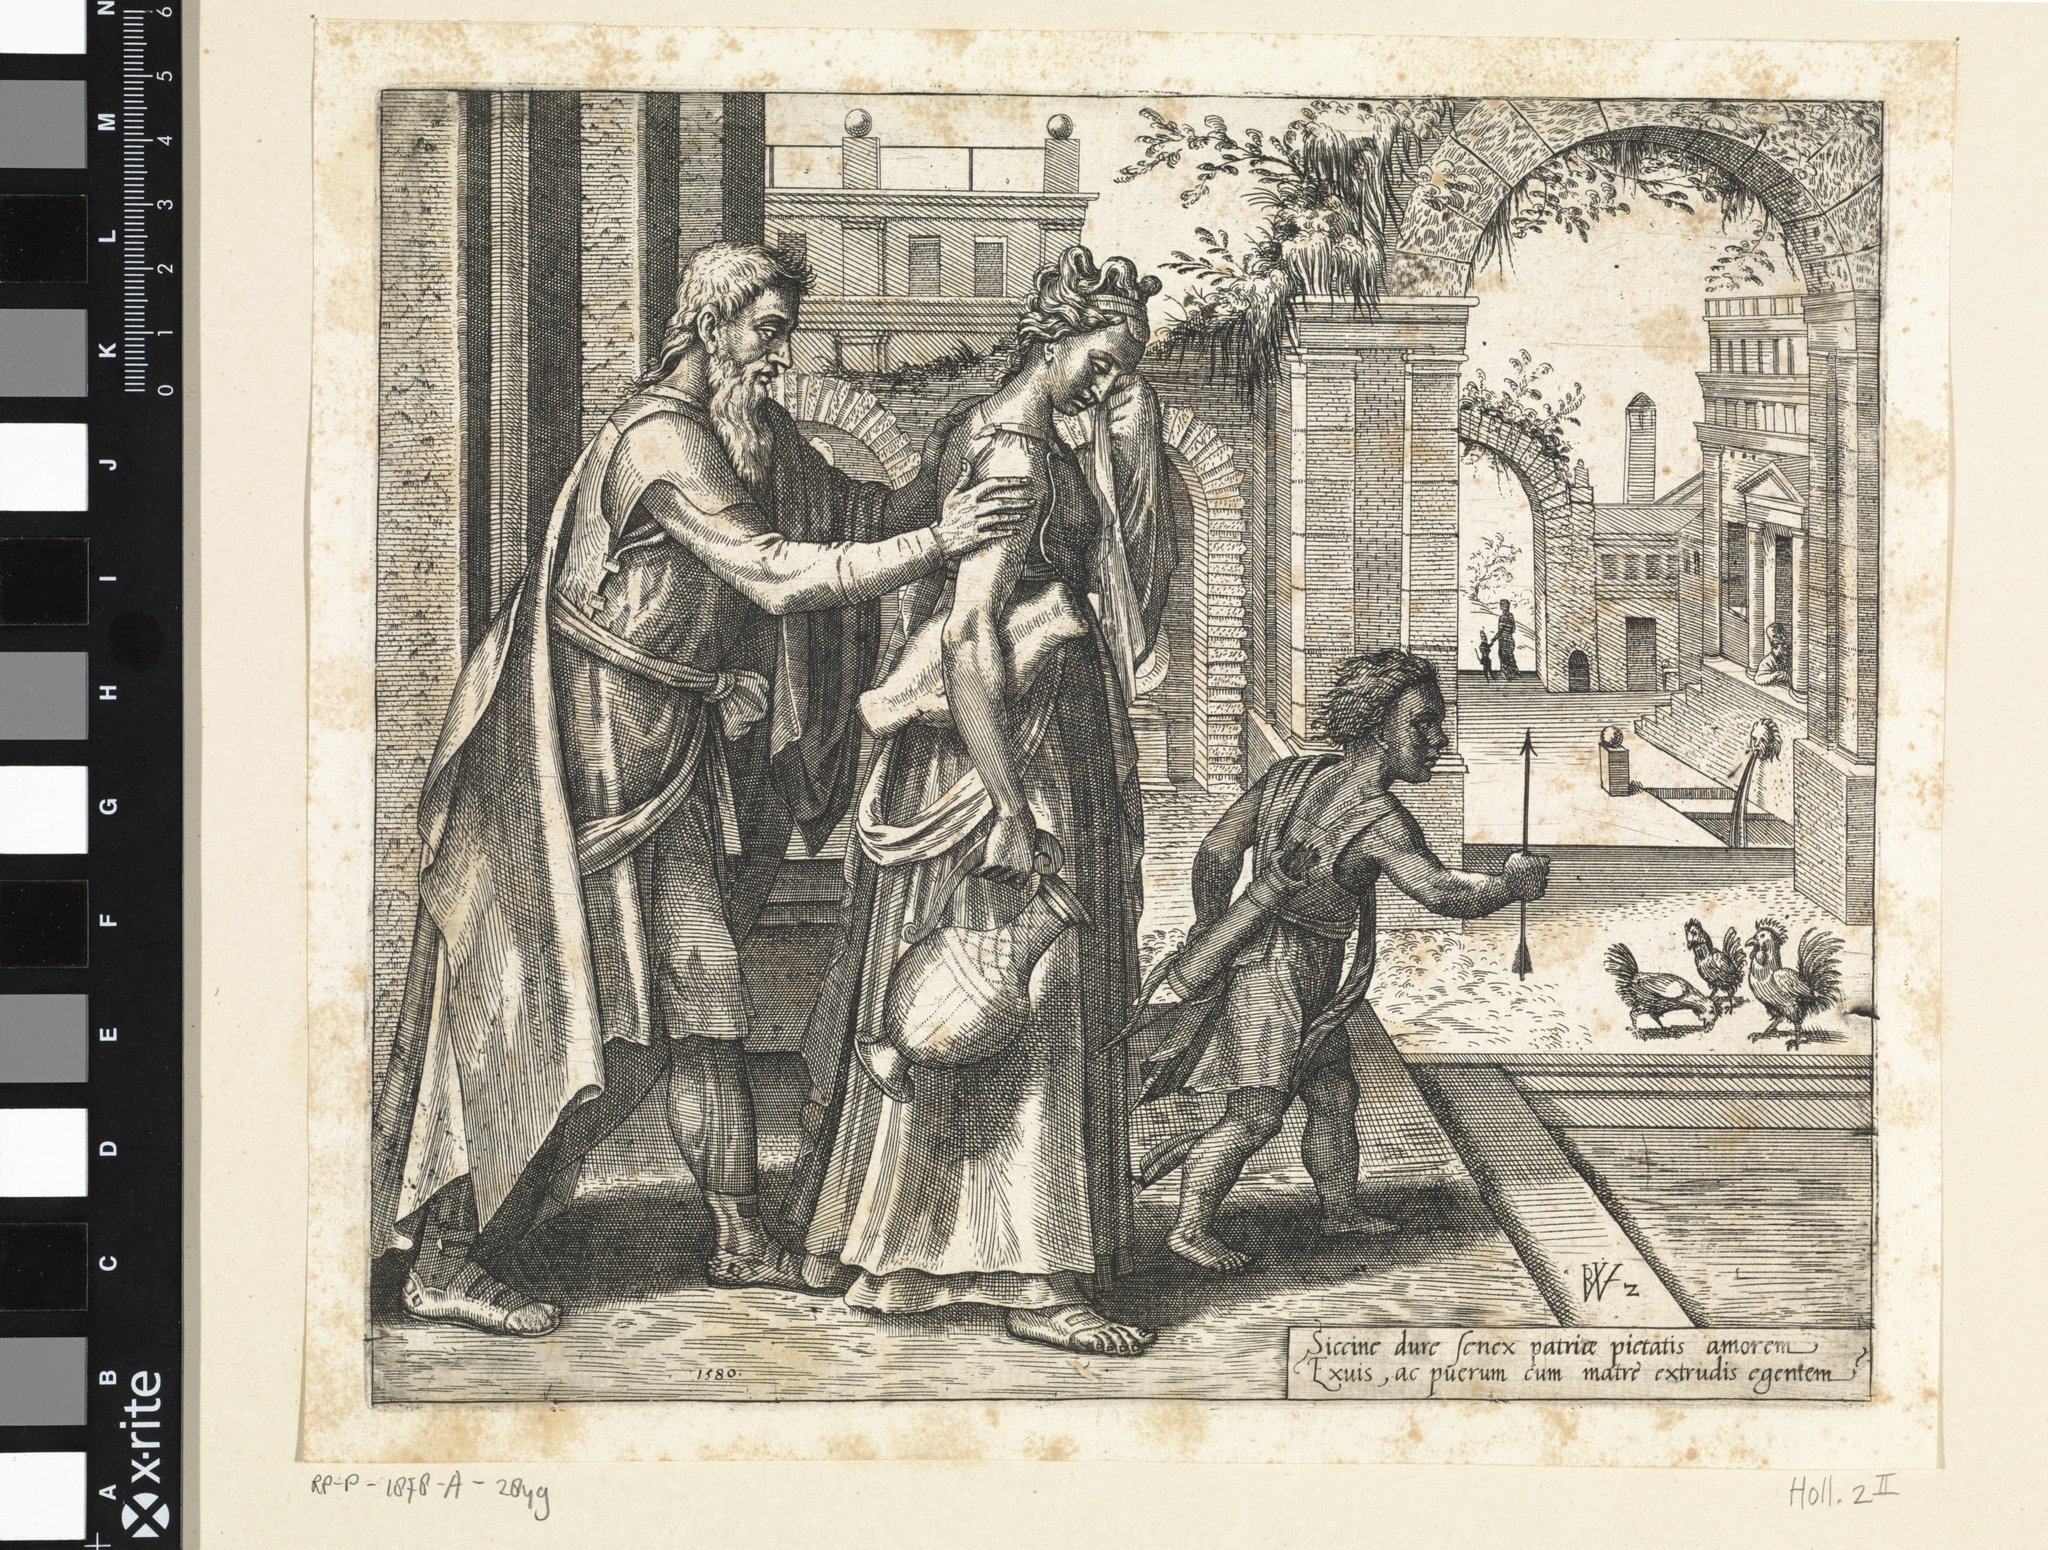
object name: print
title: Verdrijving van Hagar en Ismaël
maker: willem thibaut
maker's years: 1524-1599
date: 1580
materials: paper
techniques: engraving, etching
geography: haarlem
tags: hagar and ishmael (often with bow and arrow) depart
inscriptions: collector's mark: Lugt 2228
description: Abraham stuurt Hagar en Ismaël weg, nadat hij hen een kruik water en een brood heeft meegegeven. Op de achtergrond verlaten ze de poort. Naar de Bijbeltekst in Gen. 21: 14. Rechtsonder een tweeregelige toelichting in het Latijn.